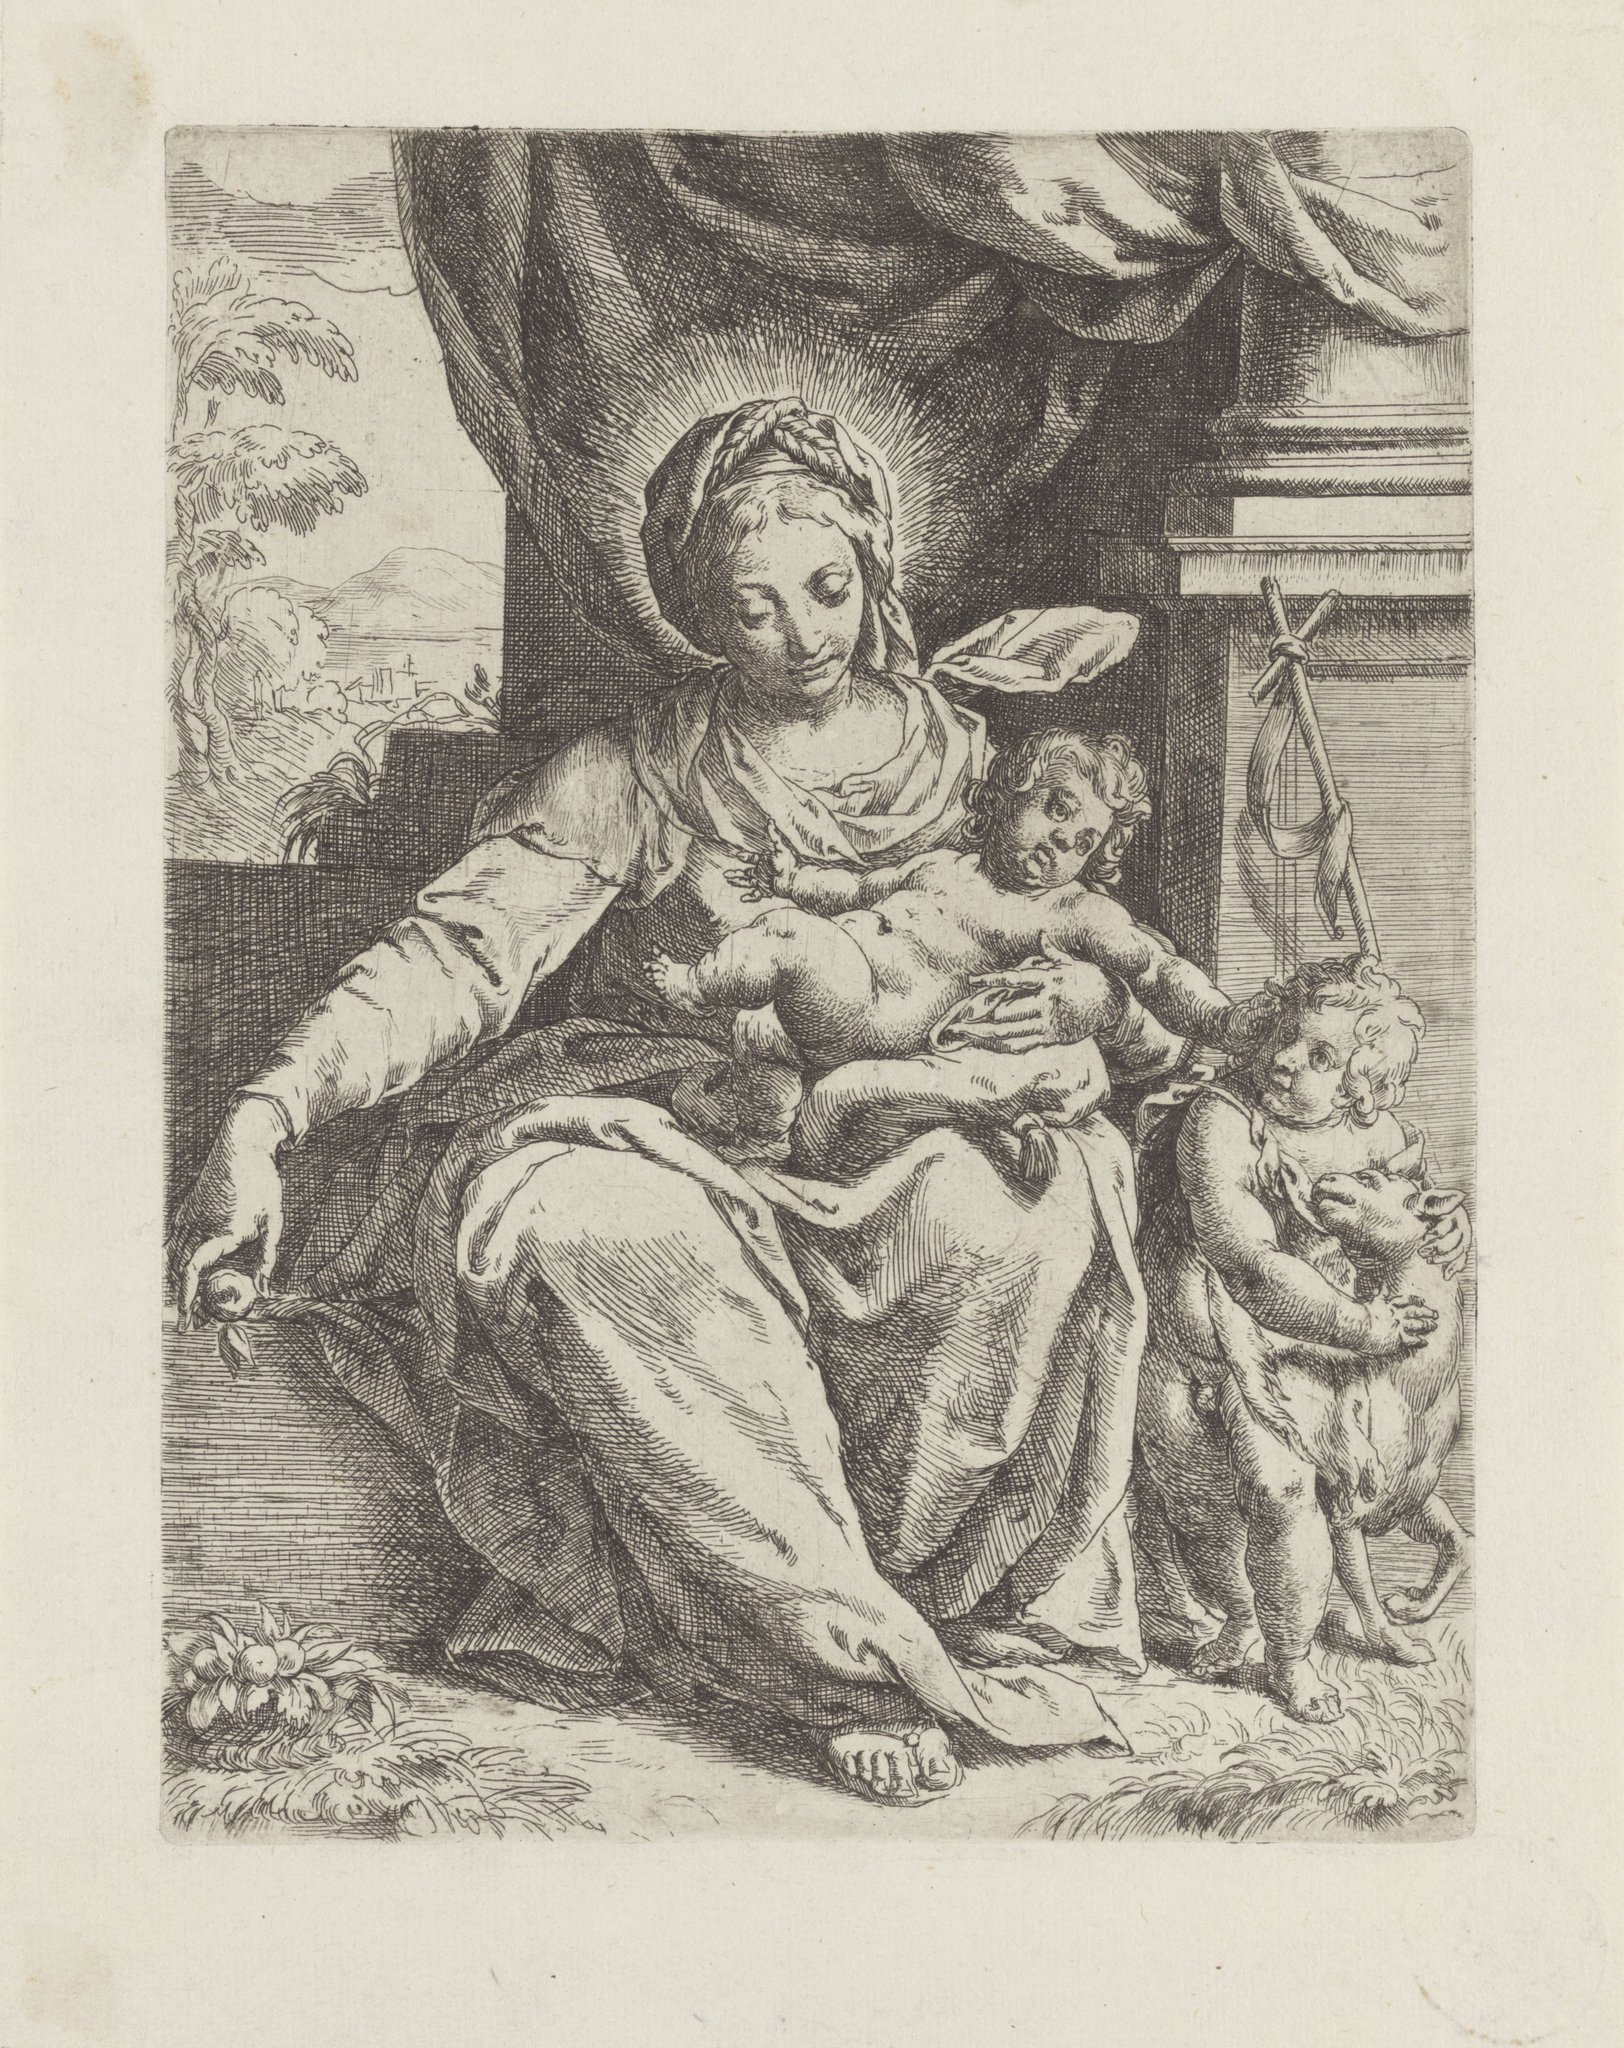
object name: print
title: Maria met Kind en de jonge Johannes de Doper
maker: gerolamo imperiale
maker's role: print maker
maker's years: -1660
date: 1622-1660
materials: paper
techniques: etching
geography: italy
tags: mary and the christ-child with john the baptist (as child)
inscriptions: collector's mark: Lugt 240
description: Maria, zittend op een laag muurtje, met in haar rechterhand een appel. Met haar linkerarm ondersteunt zij het Kind dat op haar schoot ligt. Christus reikt naar de jonge Johannes de Doper naast hem, die een bokje vasthoudt.